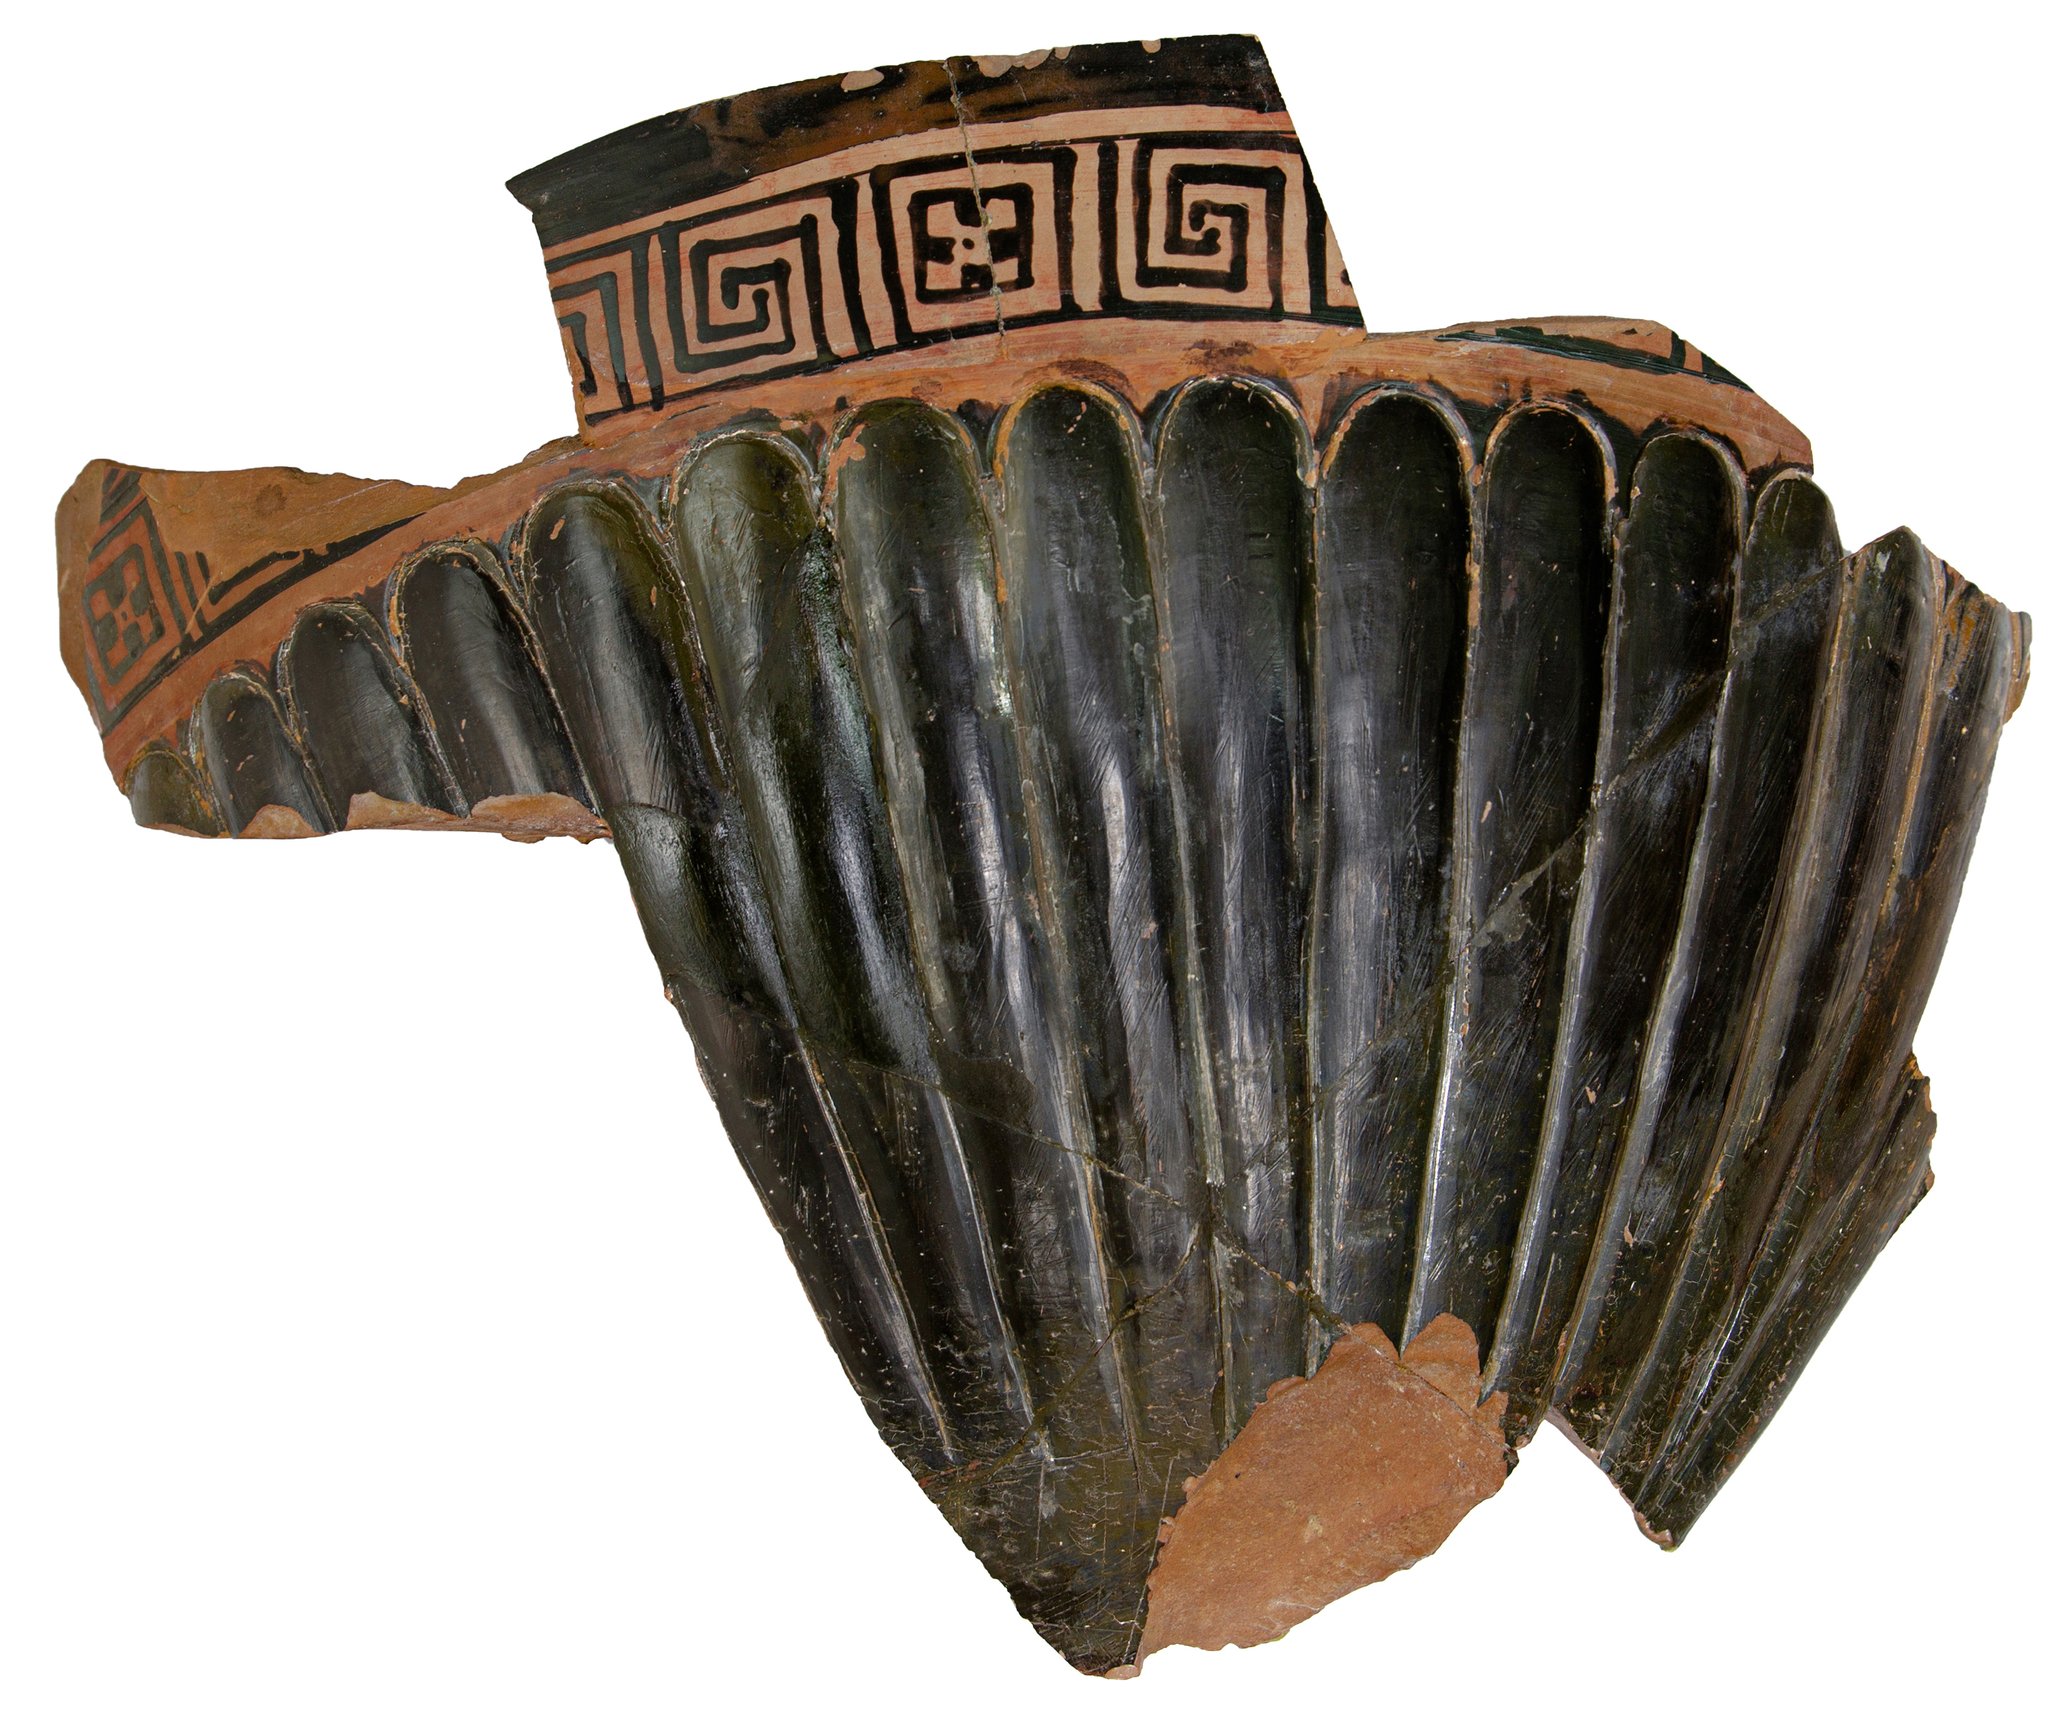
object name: volute krater fragment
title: Volute-krater fragment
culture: greek, south italian, apulian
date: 400-350 BCE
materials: terracotta